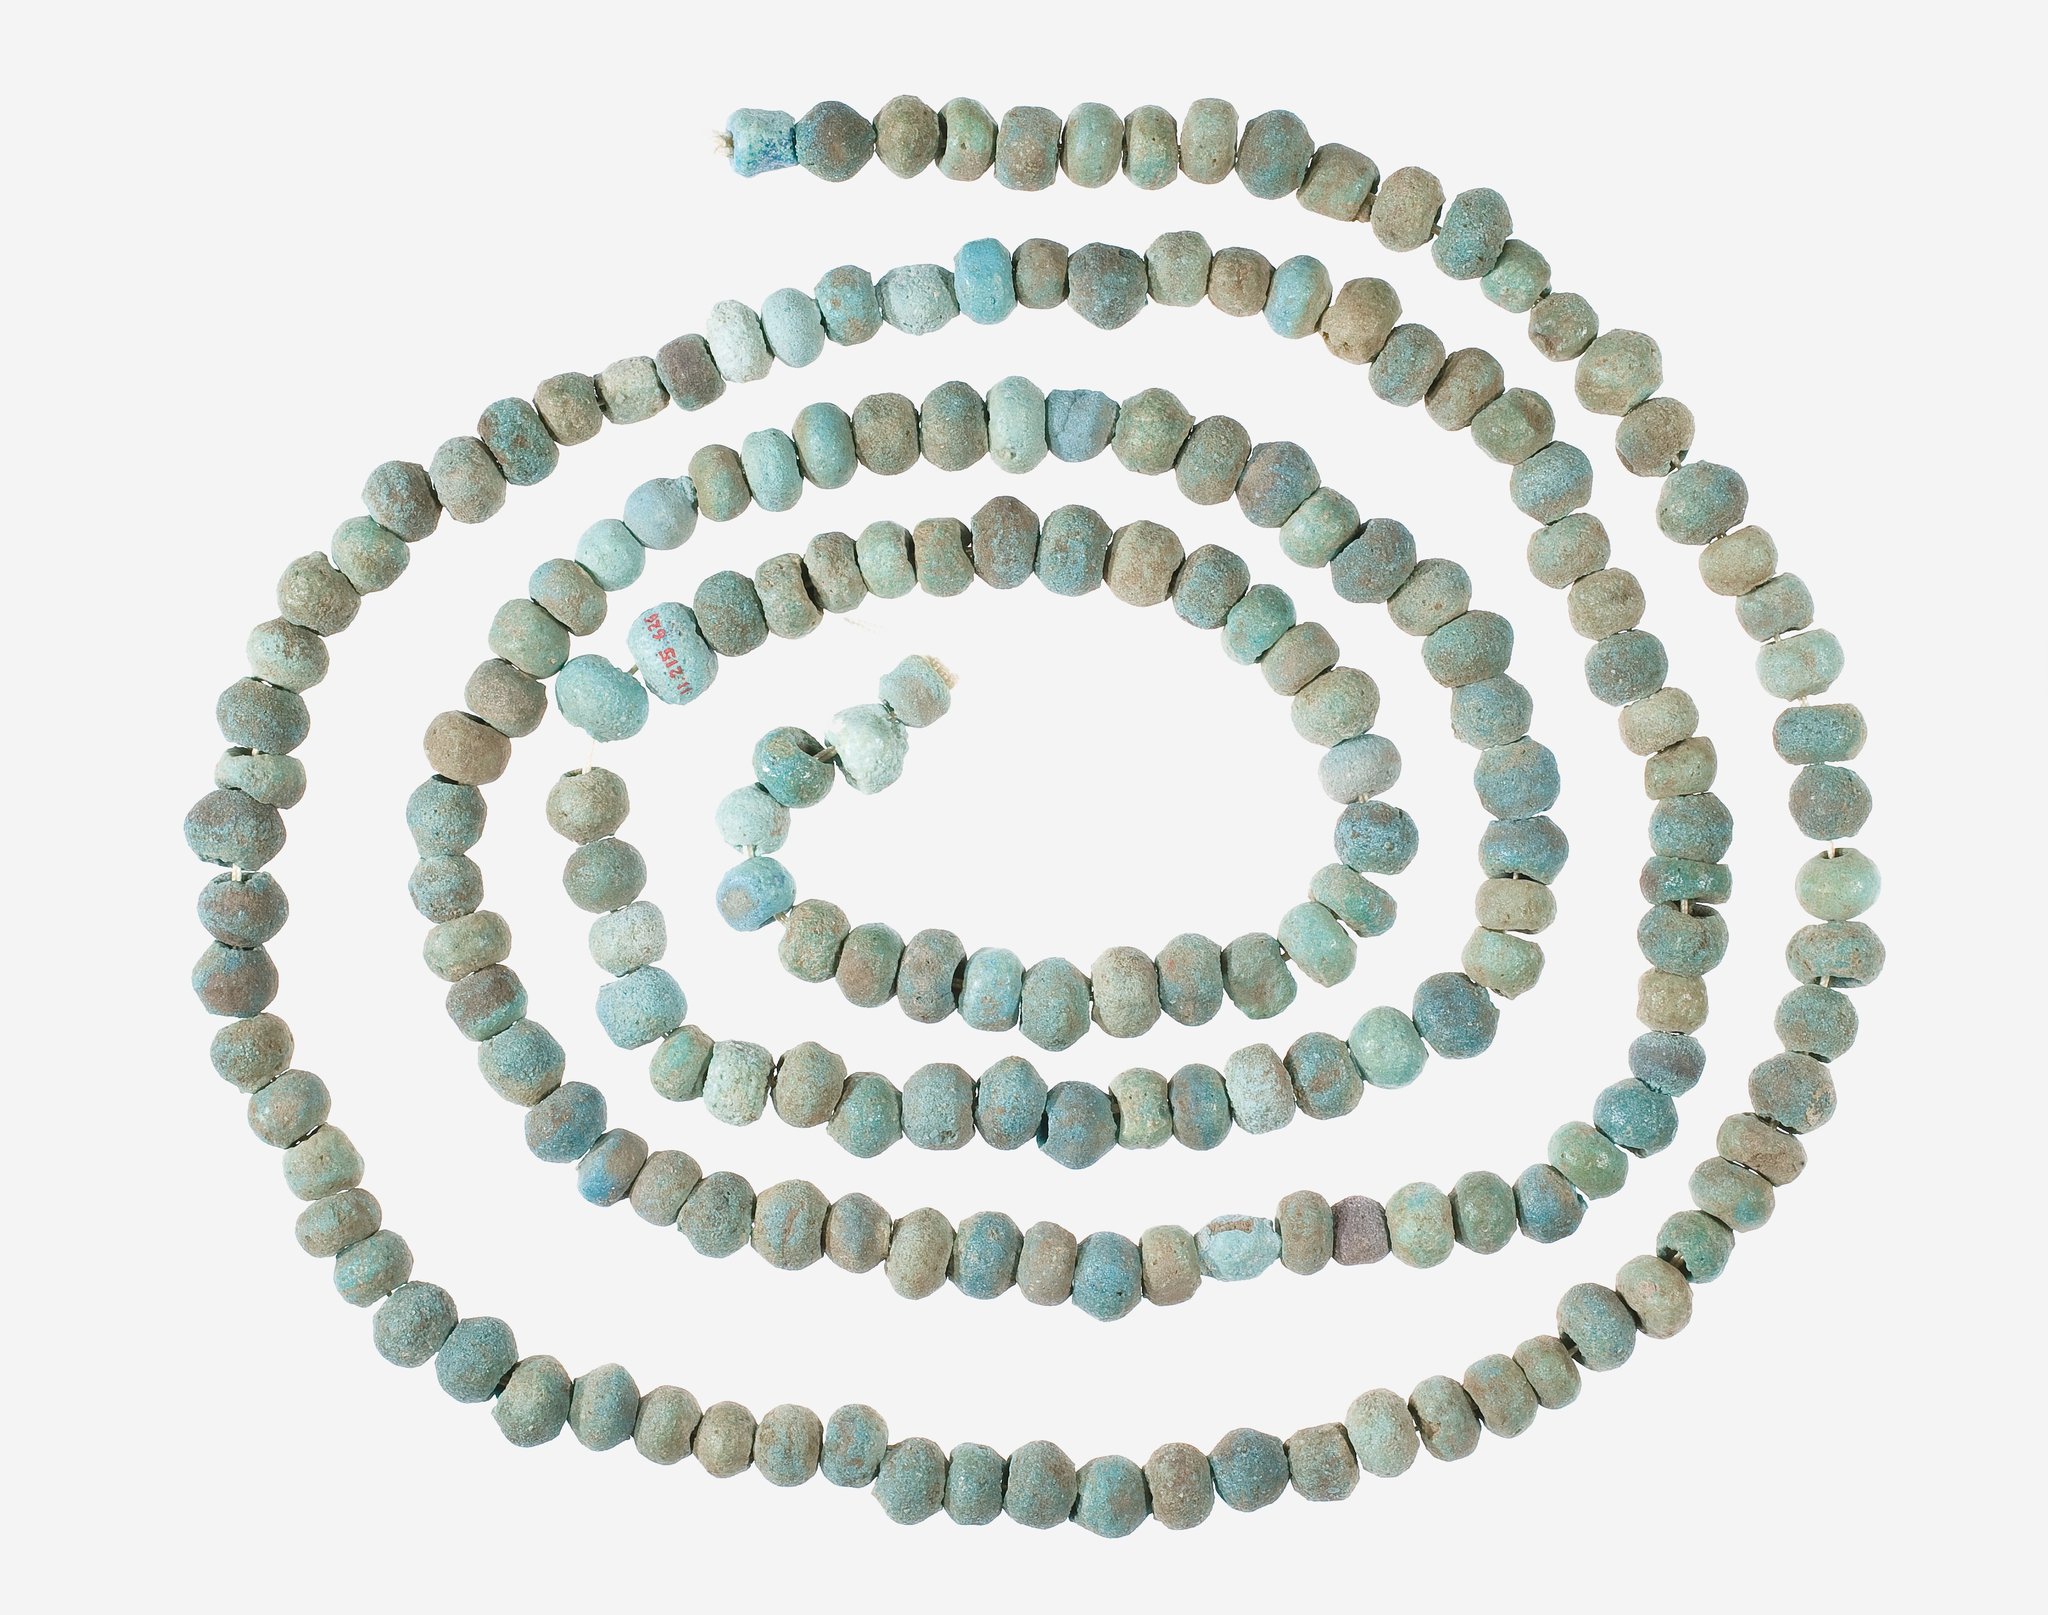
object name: bead, ball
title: String of Big Ball Beads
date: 1390-1352 BCE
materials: faience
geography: egypt